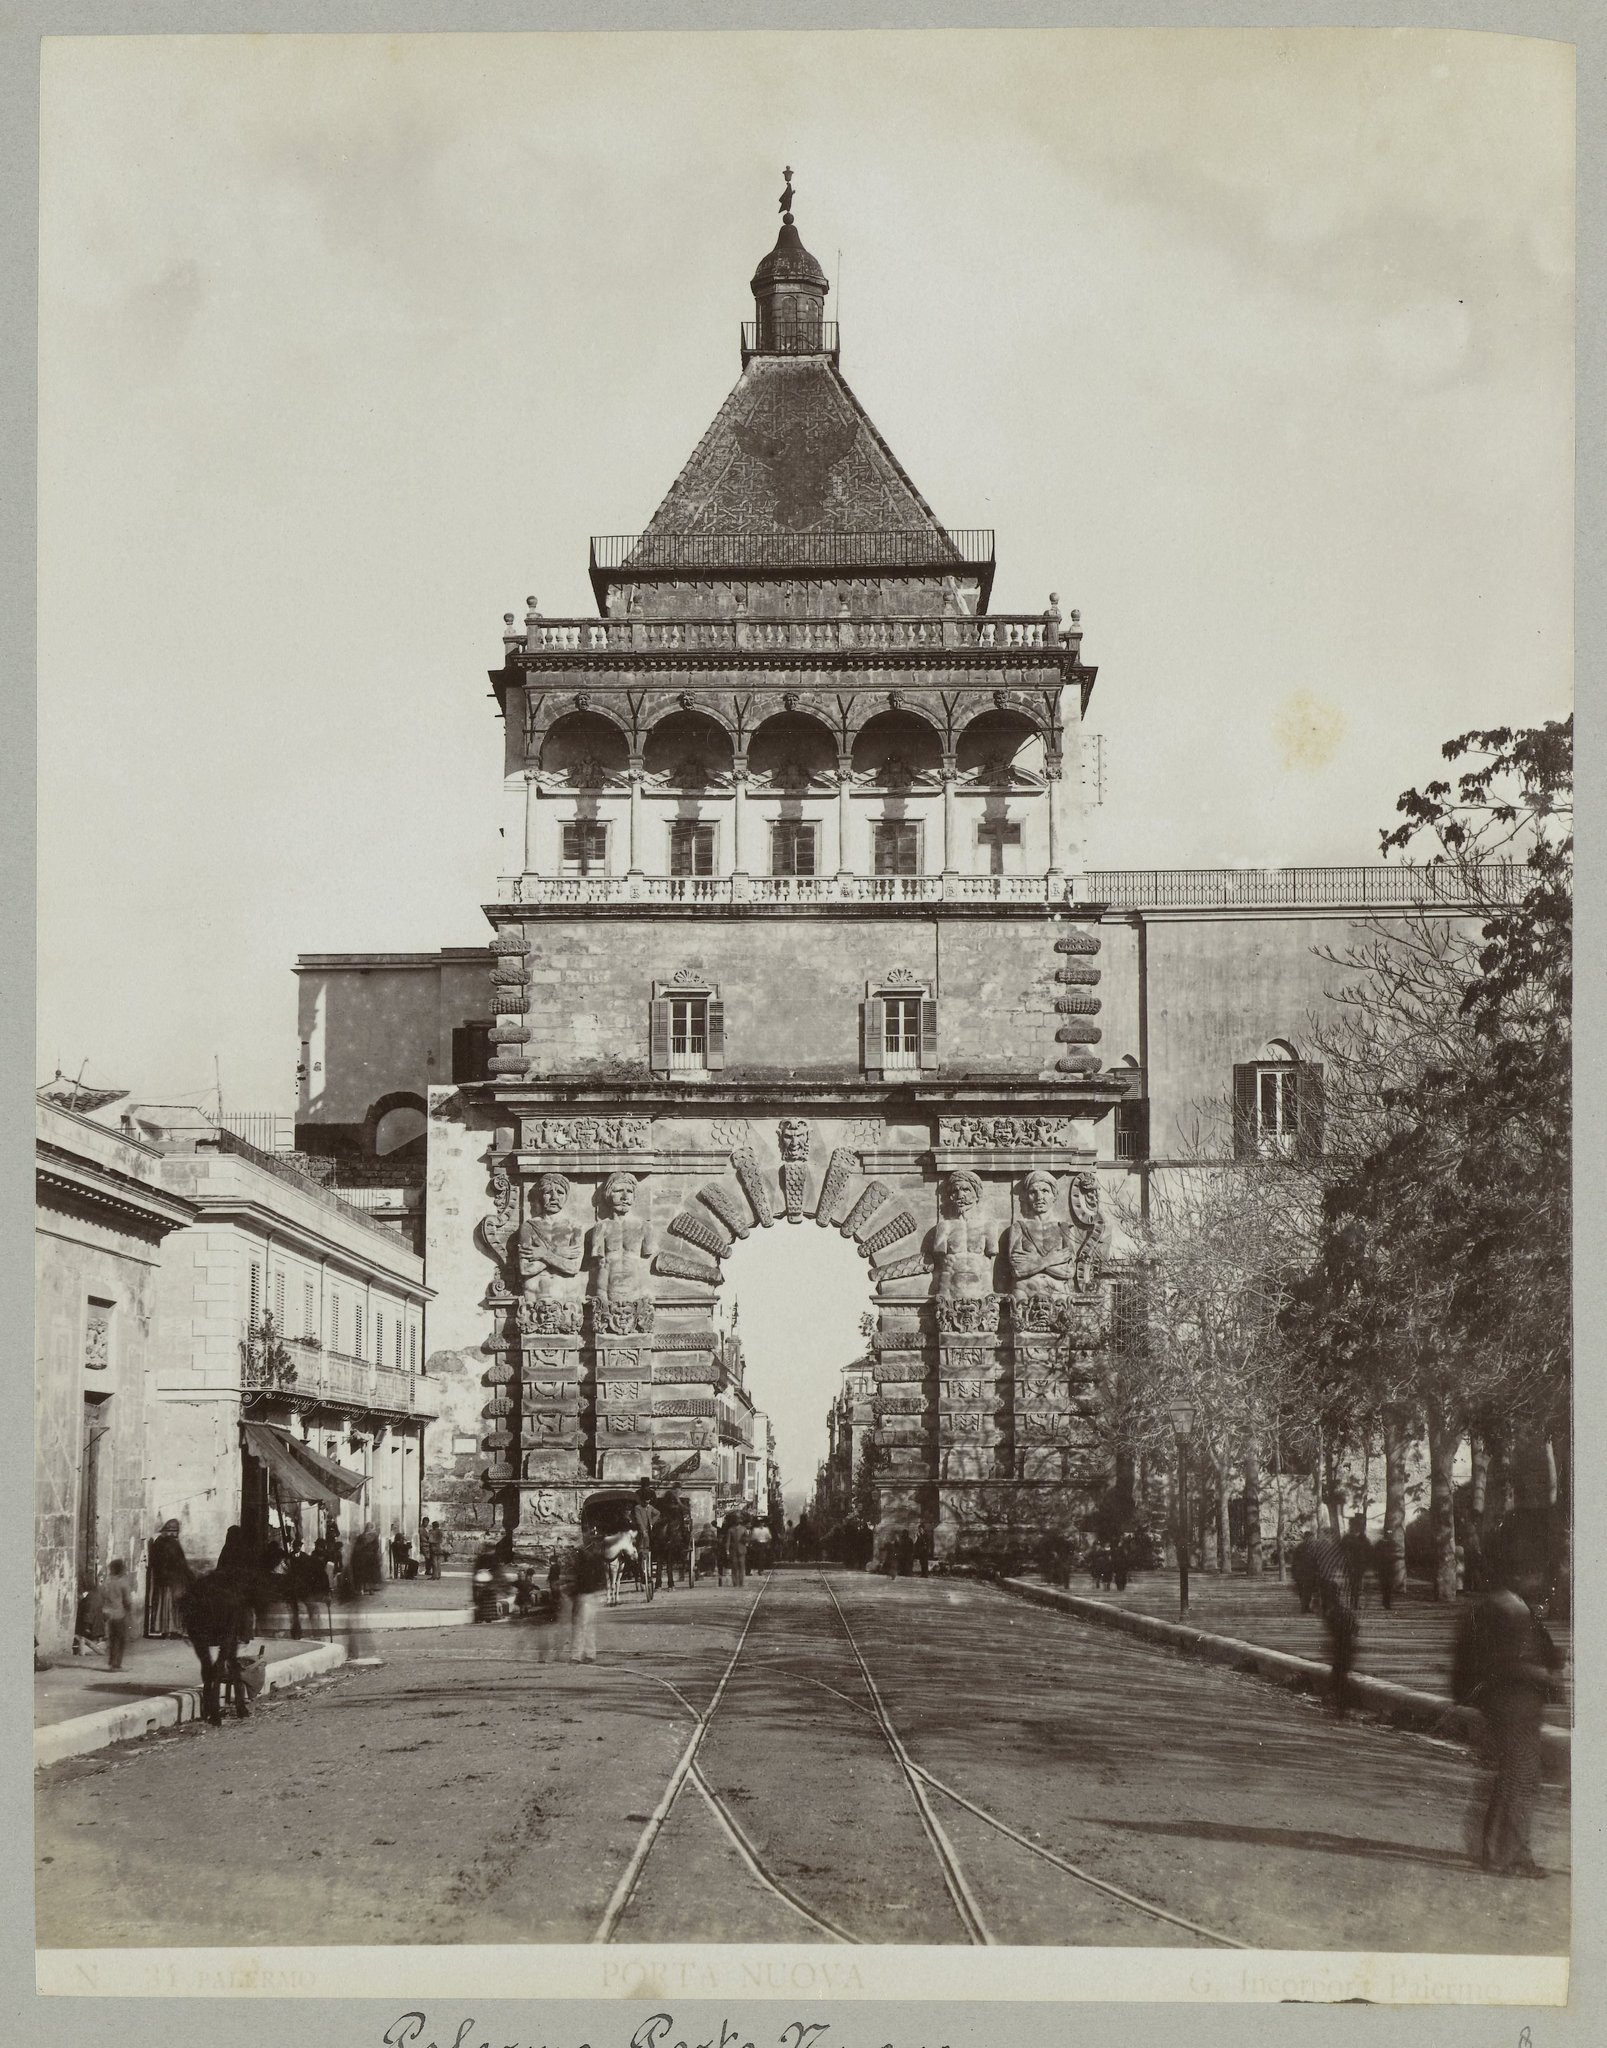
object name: photograph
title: Palermo Porta Nuova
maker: giuseppe incorpora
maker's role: fotograaf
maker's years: 1834-1914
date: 1893-1903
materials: cardboard, photographic support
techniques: albumen print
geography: netherlands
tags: palermo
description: De foto is onderdeel van een album met gekochte foto's tijdens de huwelijksreis van Henry Pauw van Wieldrecht en Johanna Elisabeth Boissevain in 1903.